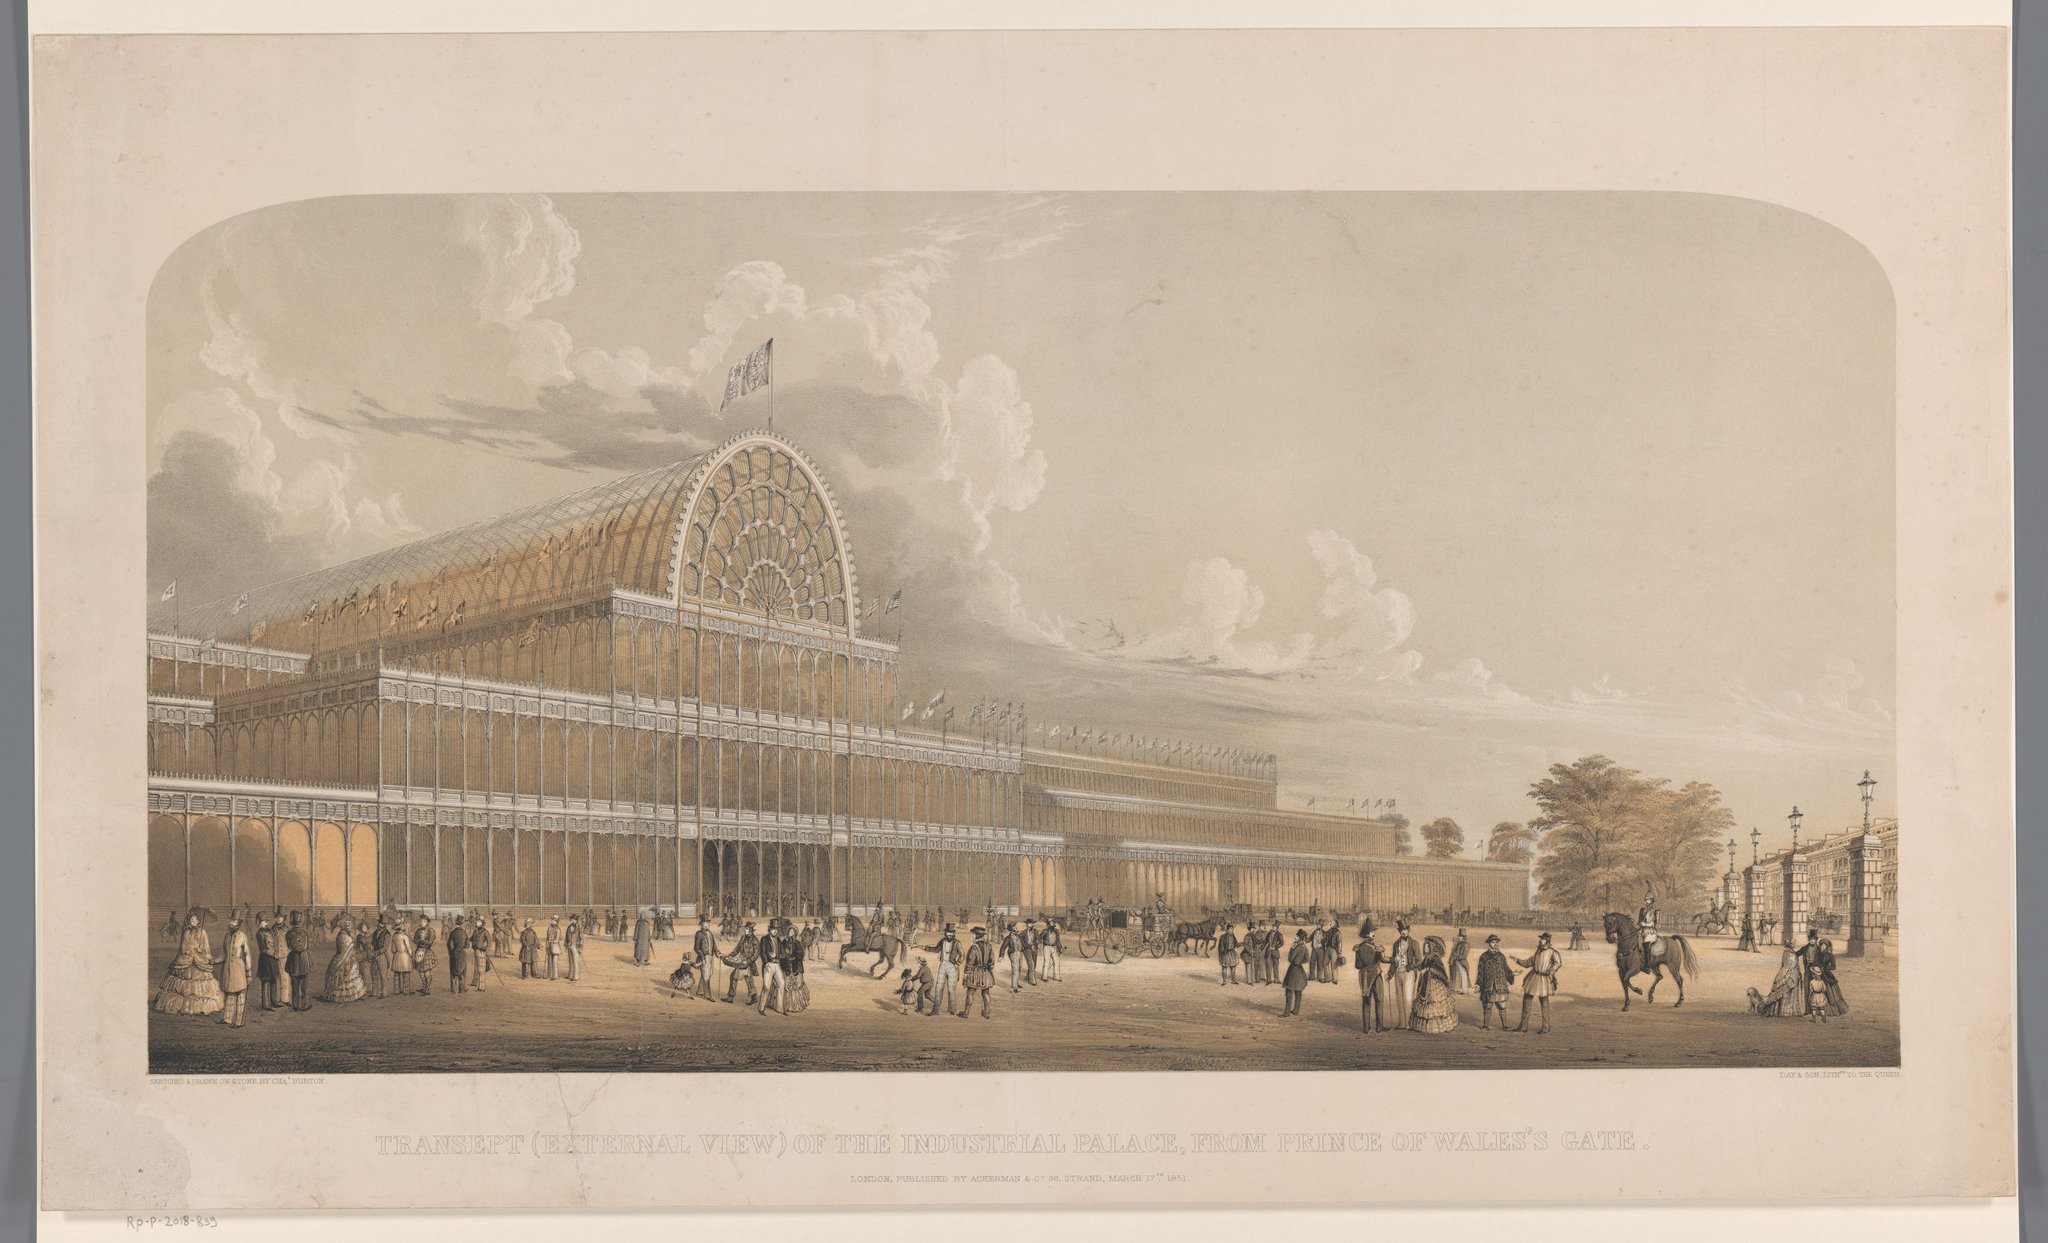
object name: print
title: Gezicht op het Crystal Palace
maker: charles burton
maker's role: print maker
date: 1851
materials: paper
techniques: lithograph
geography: london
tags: world fair, world exhibition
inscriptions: date